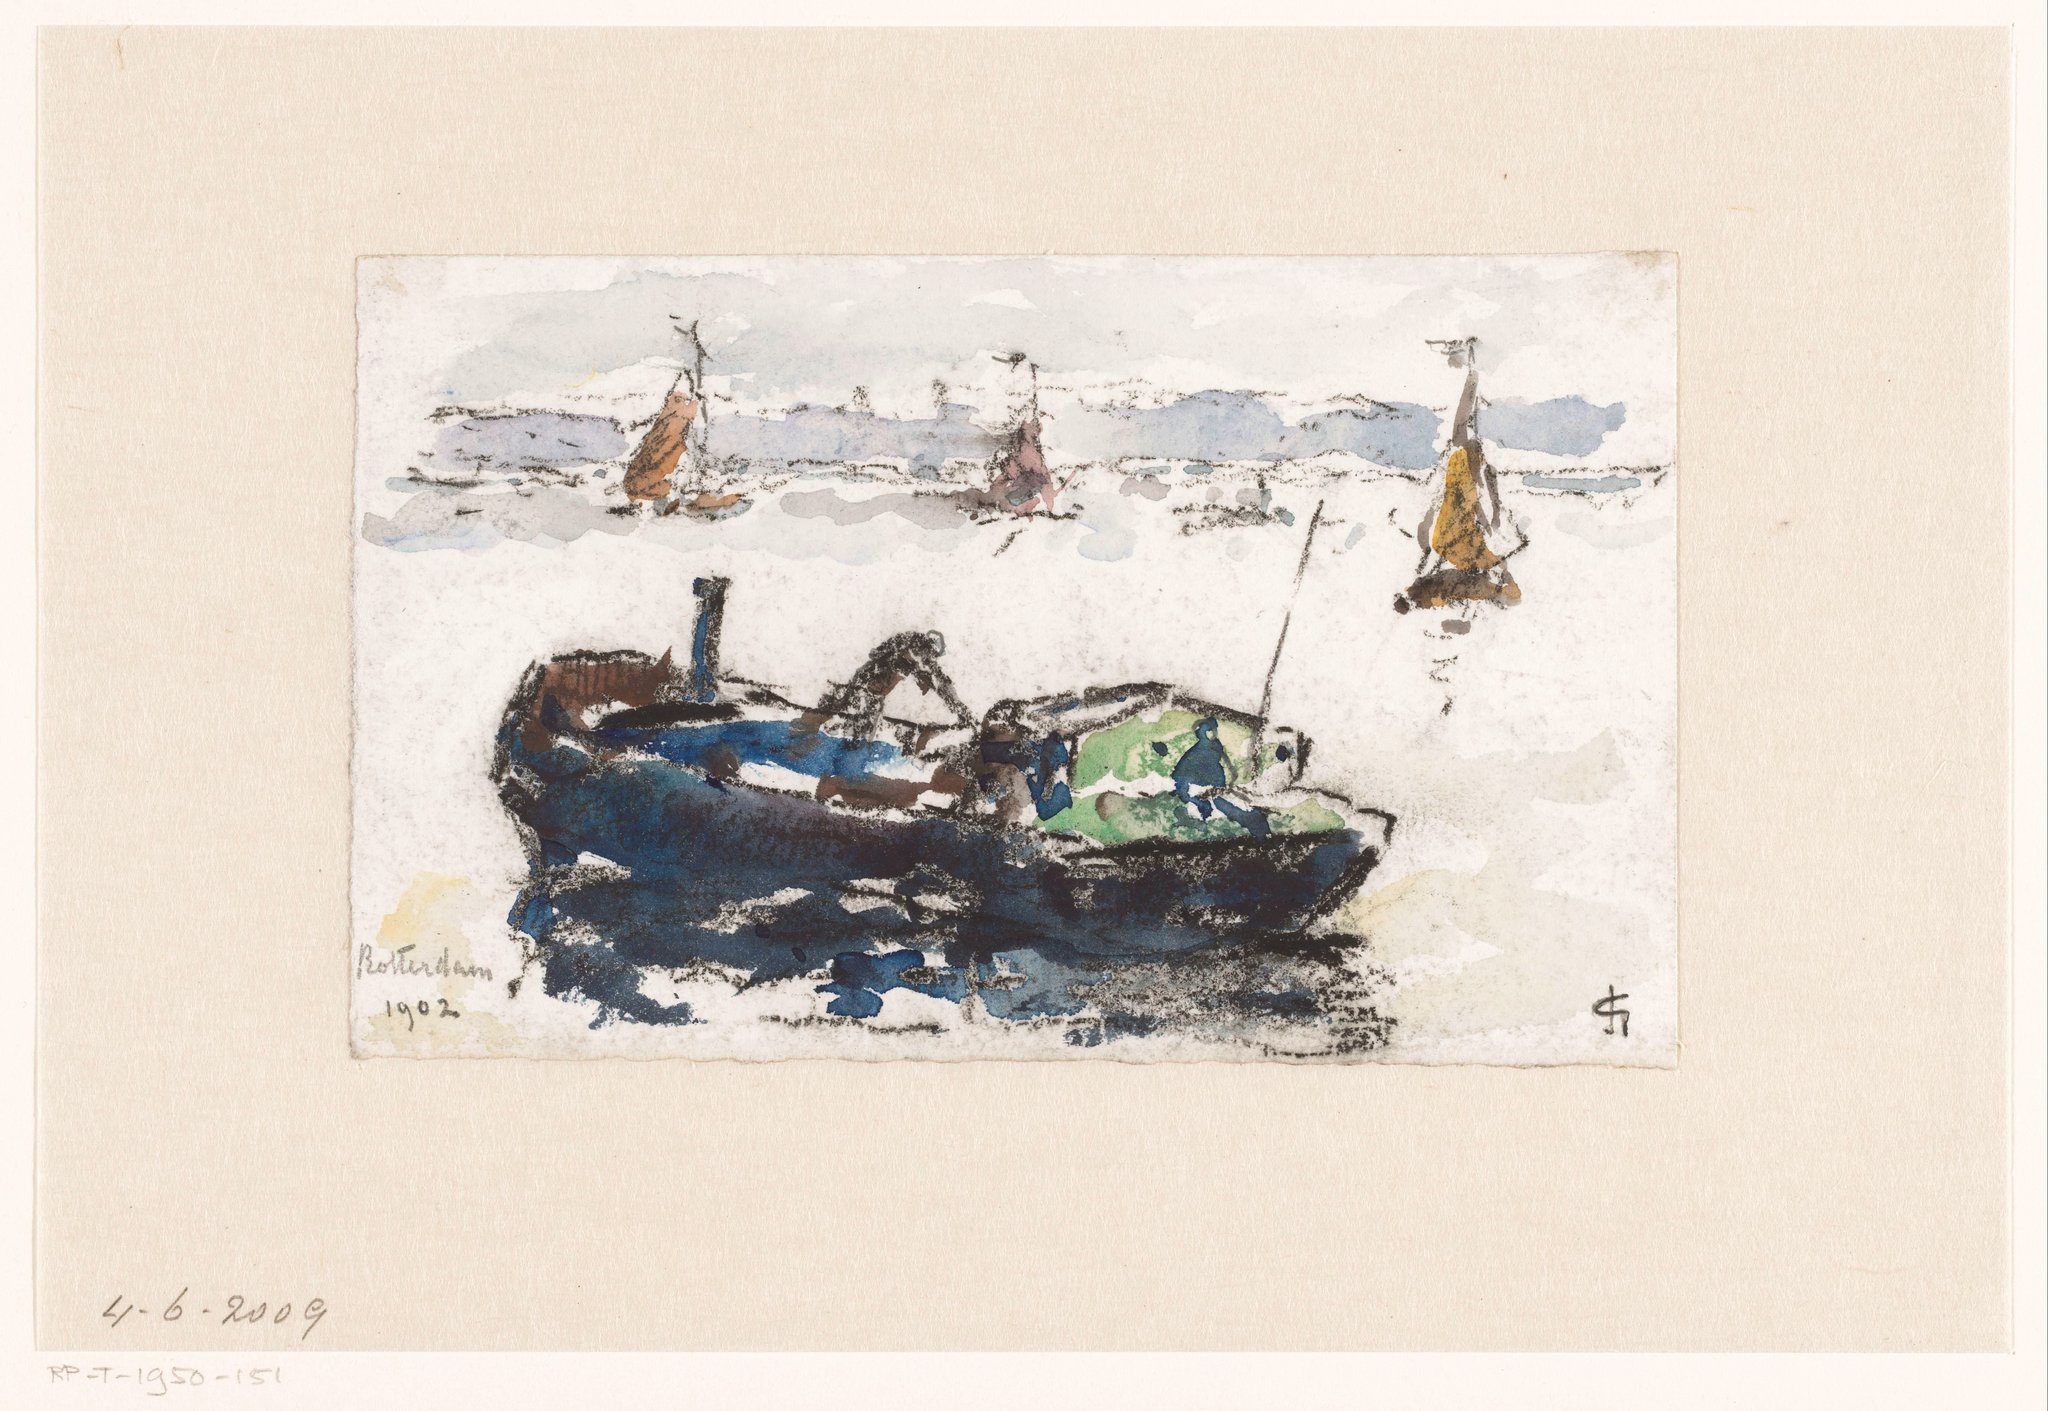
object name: watercolor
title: Gezicht op de Maas bij Rotterdam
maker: carel nicolaas storm van s-gravesande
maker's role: draughtsman, print maker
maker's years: 1841-1924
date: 1902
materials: chalk, paper, watercolor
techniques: brush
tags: ships (in general) - cc - more than one ship, rotterdam